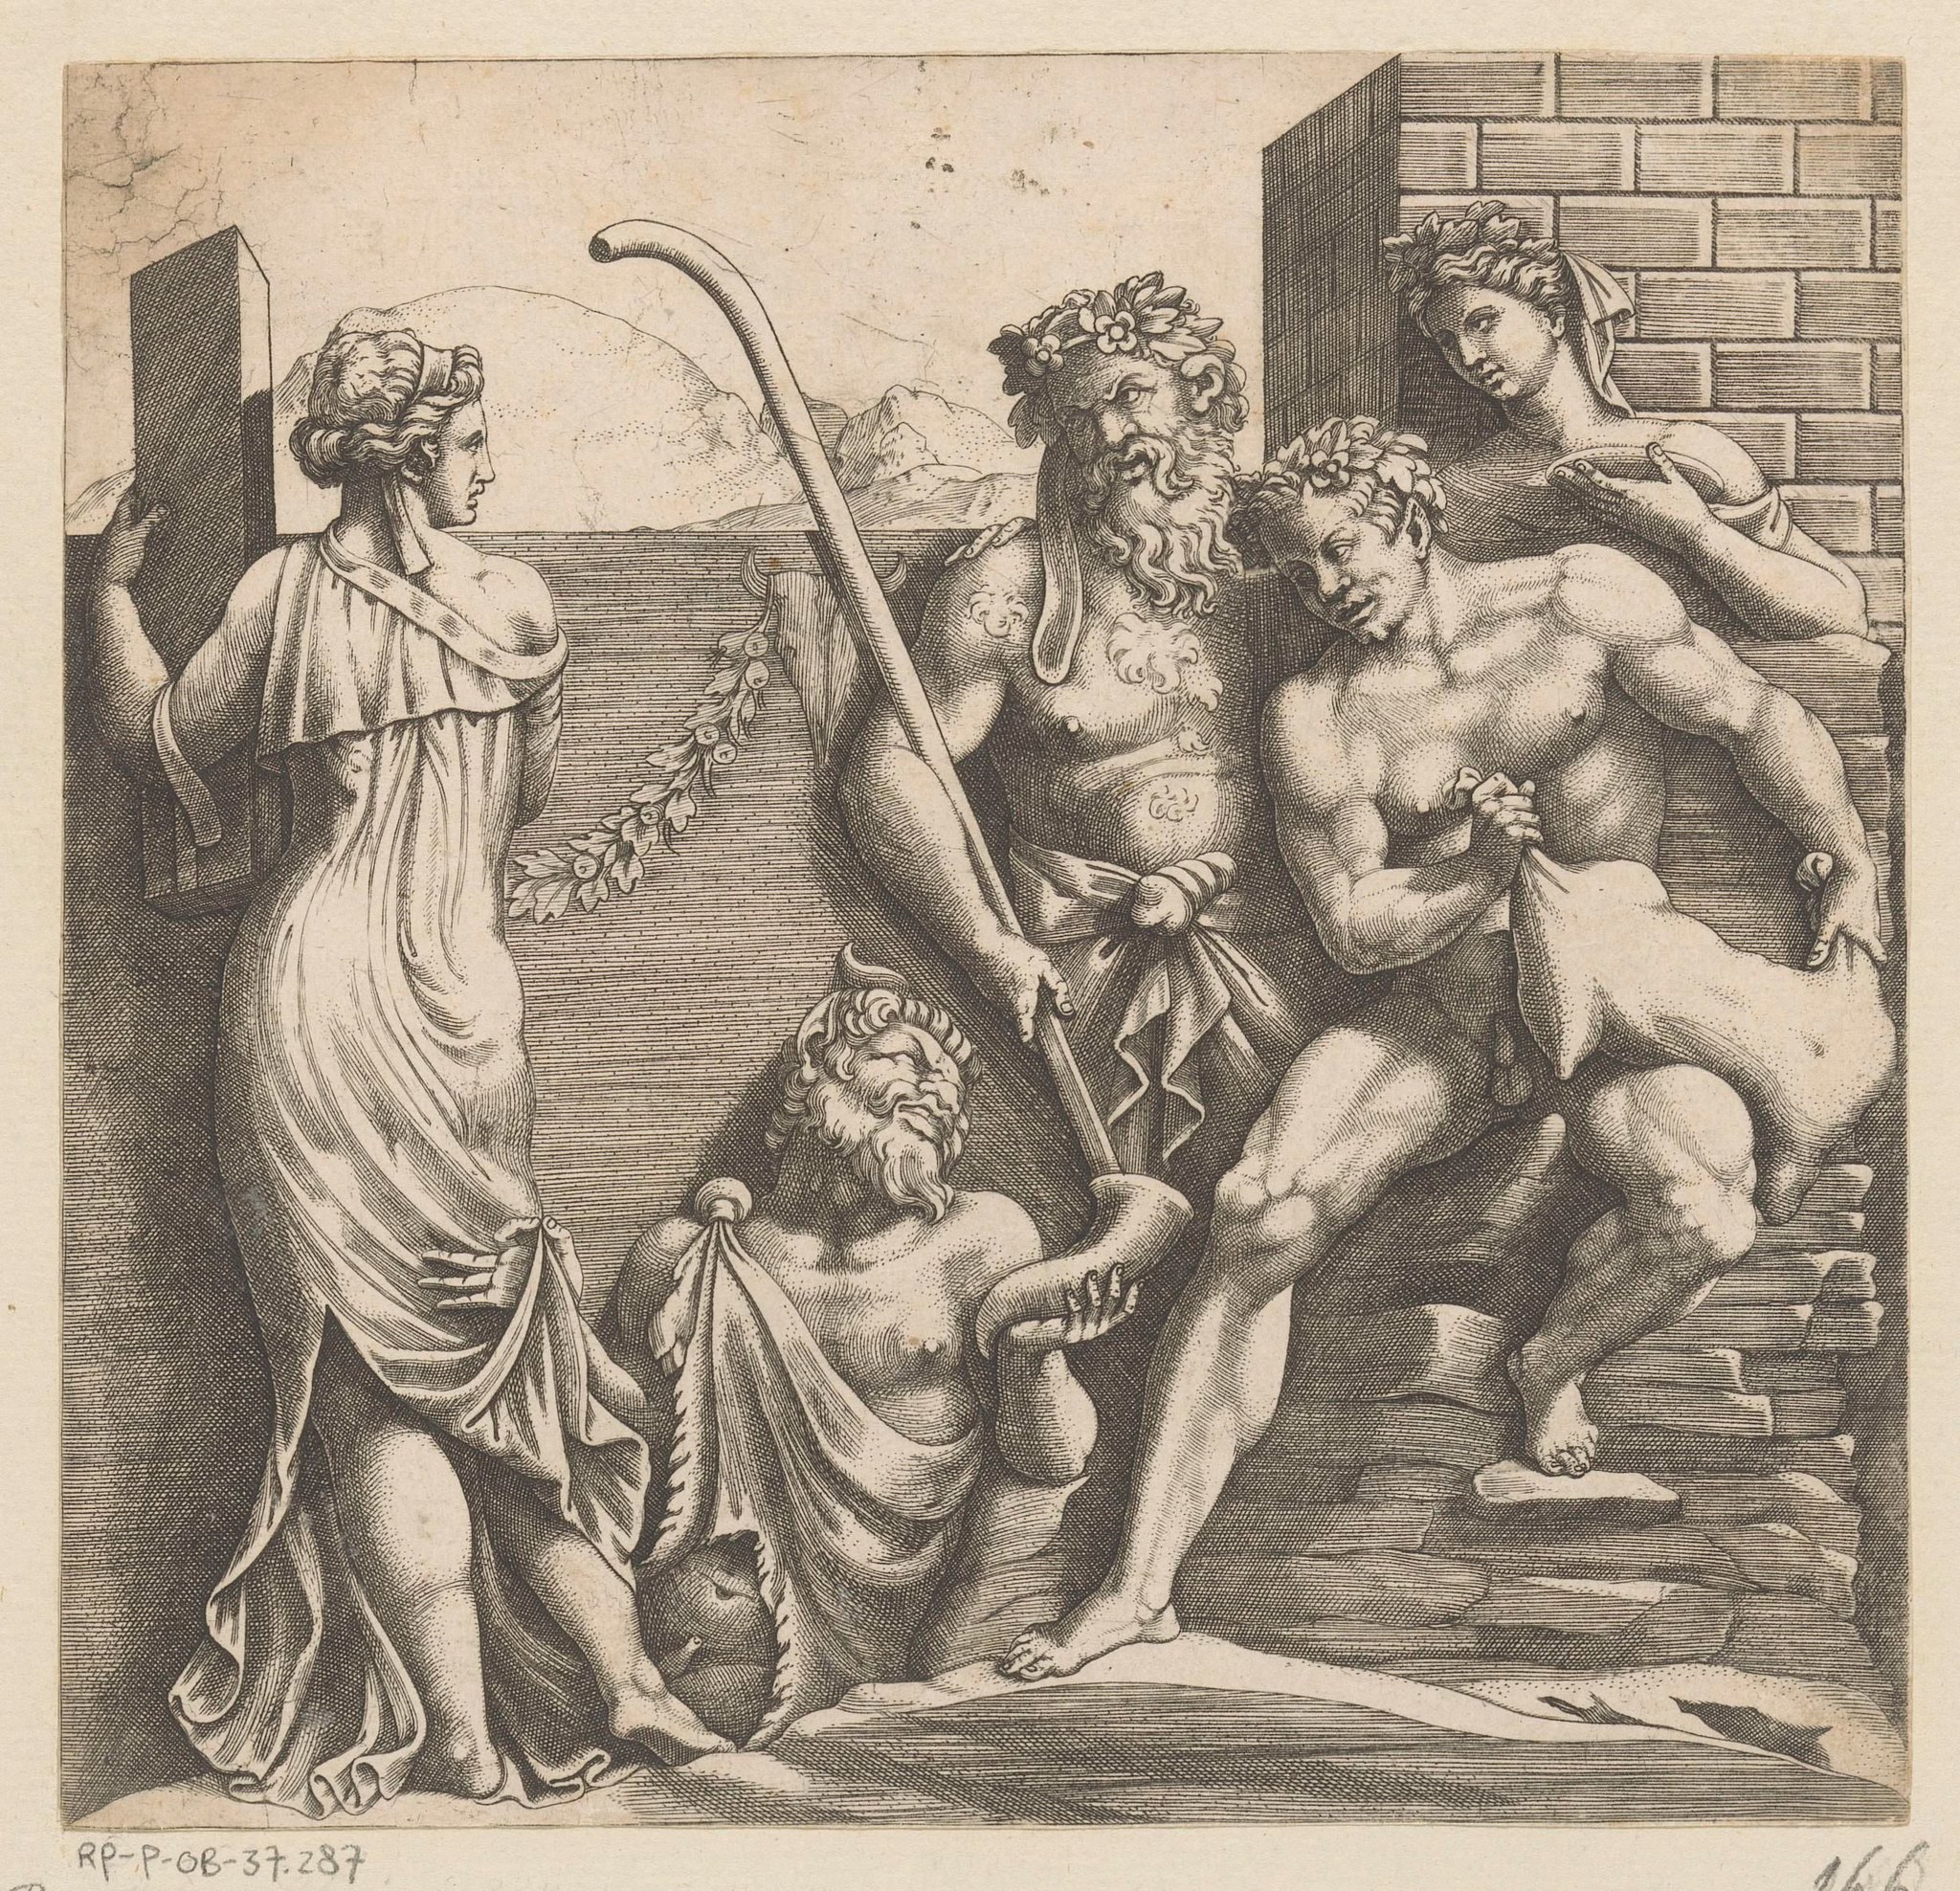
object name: print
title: Bacchanaal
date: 1540-1585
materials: paper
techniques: engraving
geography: italy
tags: maenad(s), female bacchant(es), satyr(s) (in general), drinking-horn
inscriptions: collector's mark: Lugt 240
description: Een bacchanaal met rechts een zittende man met een lapzak (een zak waaruit gedronken werd). Naast hem een bebaarde man met een staf. Op de grond een sater met een hoorn. Links en rechts een maenade.